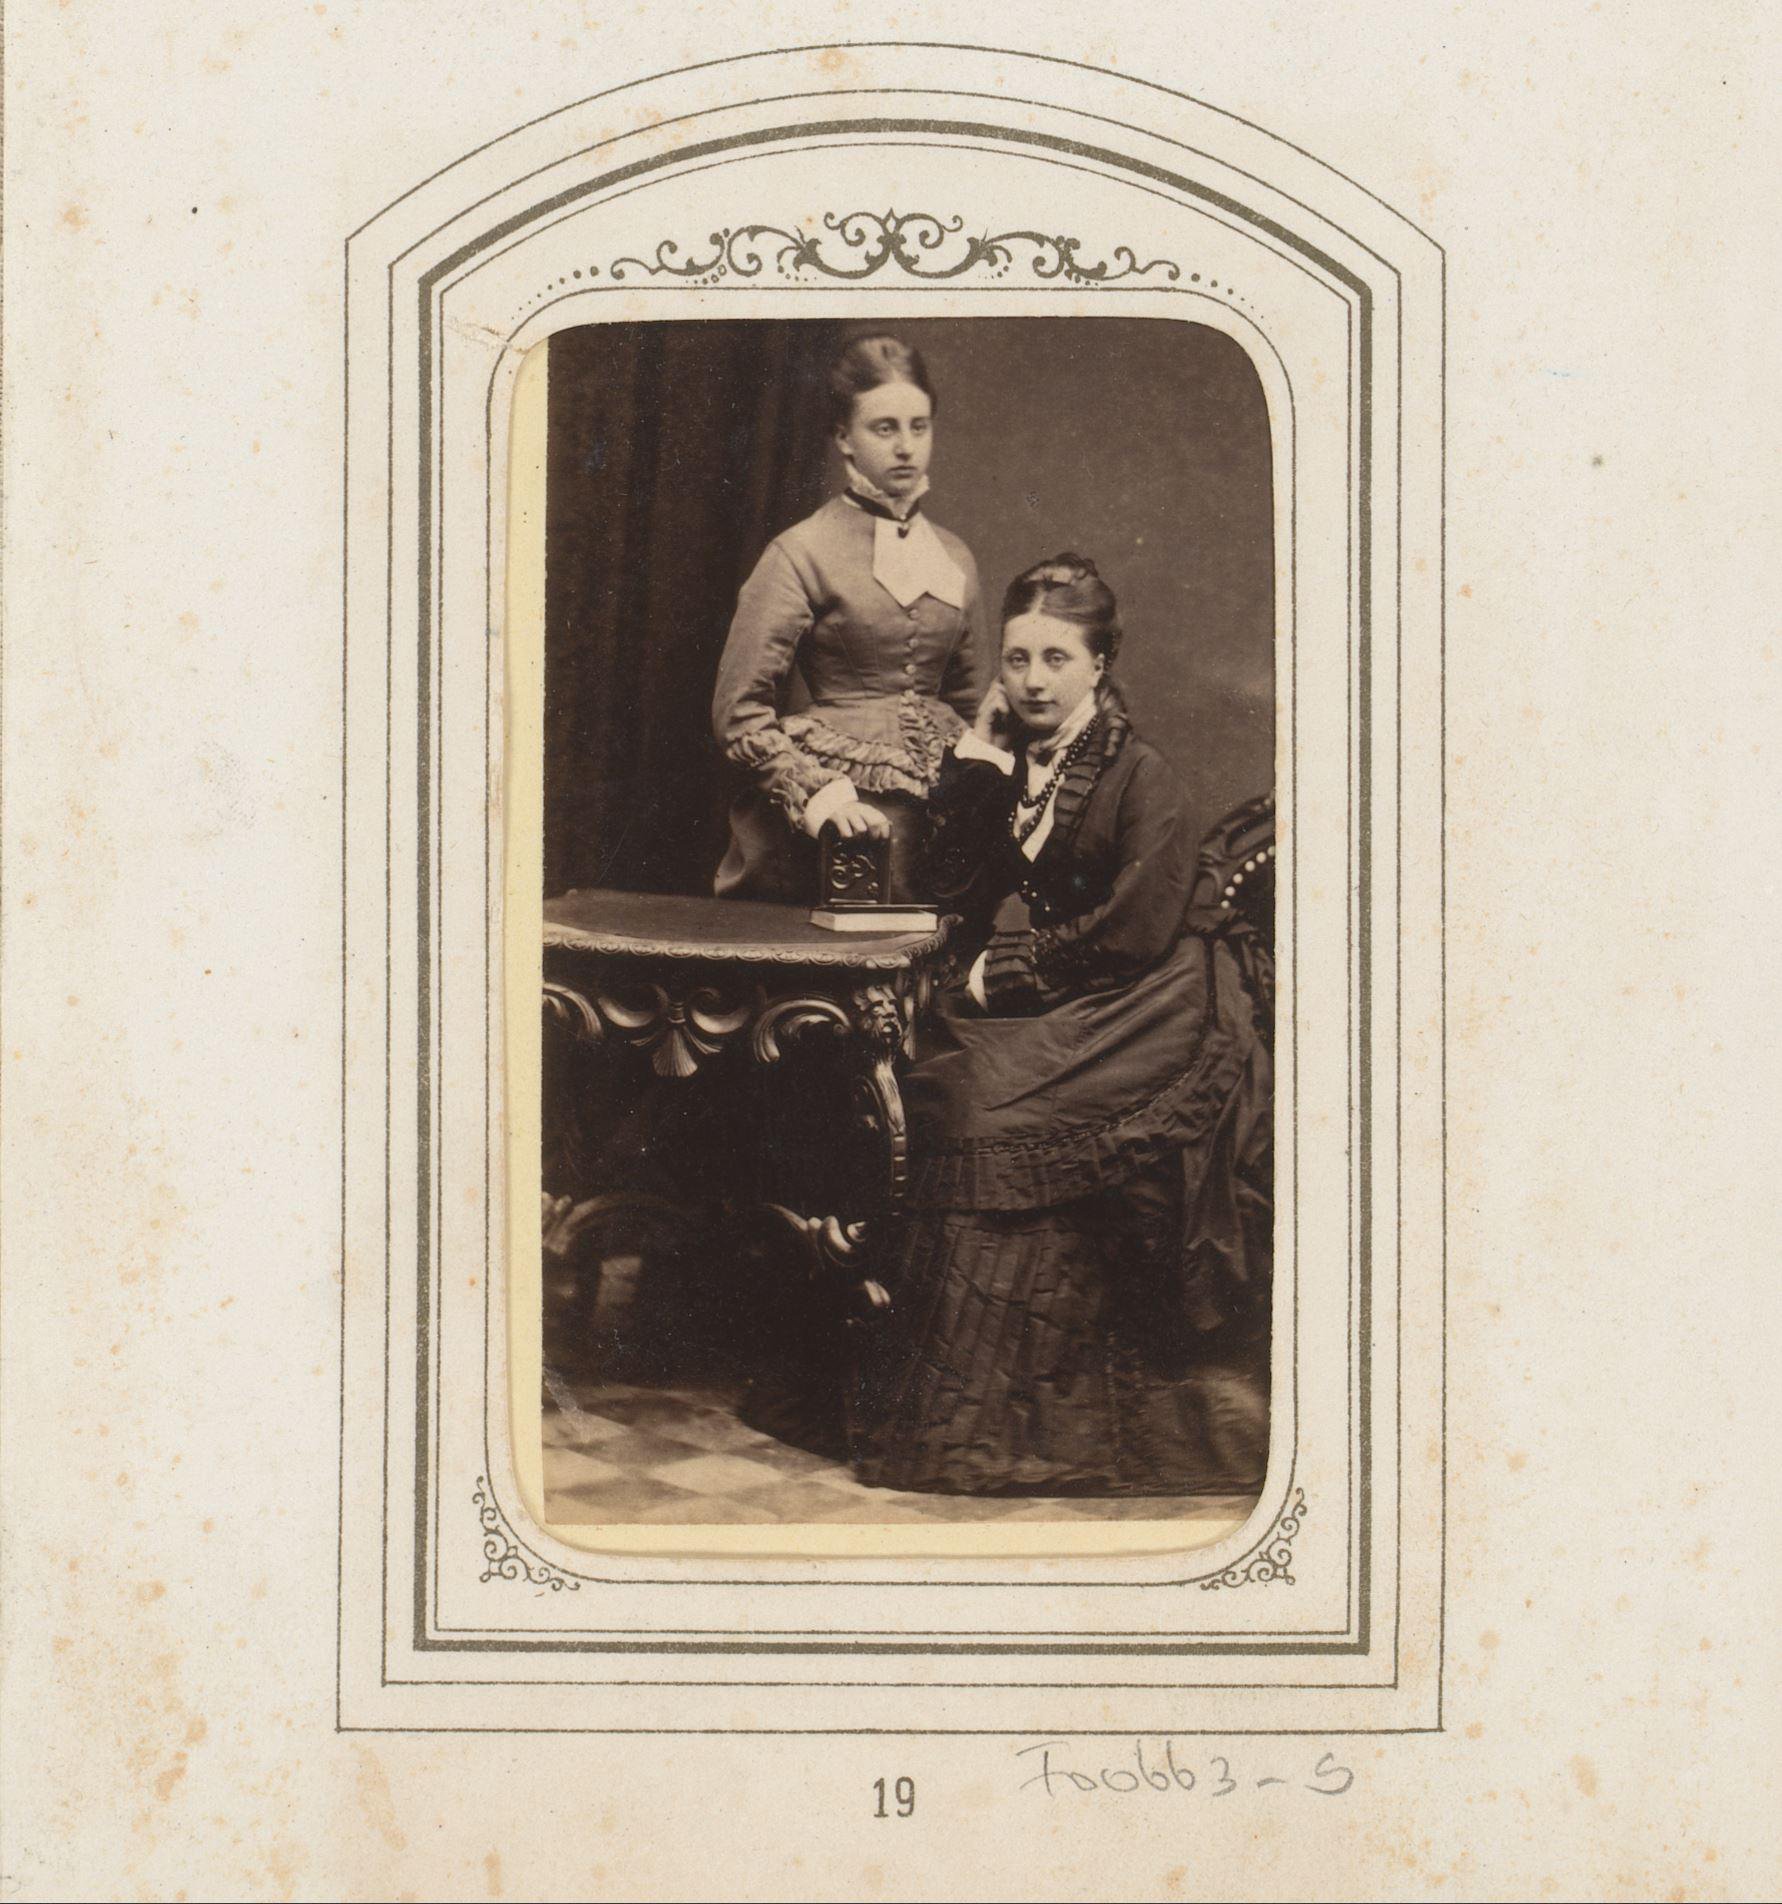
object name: photograph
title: Portret van twee vrouwen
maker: hendrik anthonie karel ringler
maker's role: draughtsman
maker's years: 1846-1879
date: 1872-1879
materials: cardboard, photographic support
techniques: albumen print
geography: leeuwarden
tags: historical persons - bb - woman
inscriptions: number: ‘19’, inscription: ‘Photografisch Atelier/ H.A.K. Ringler/ Leeuwarden/ Weststraat bij het Zaailand No. 270’